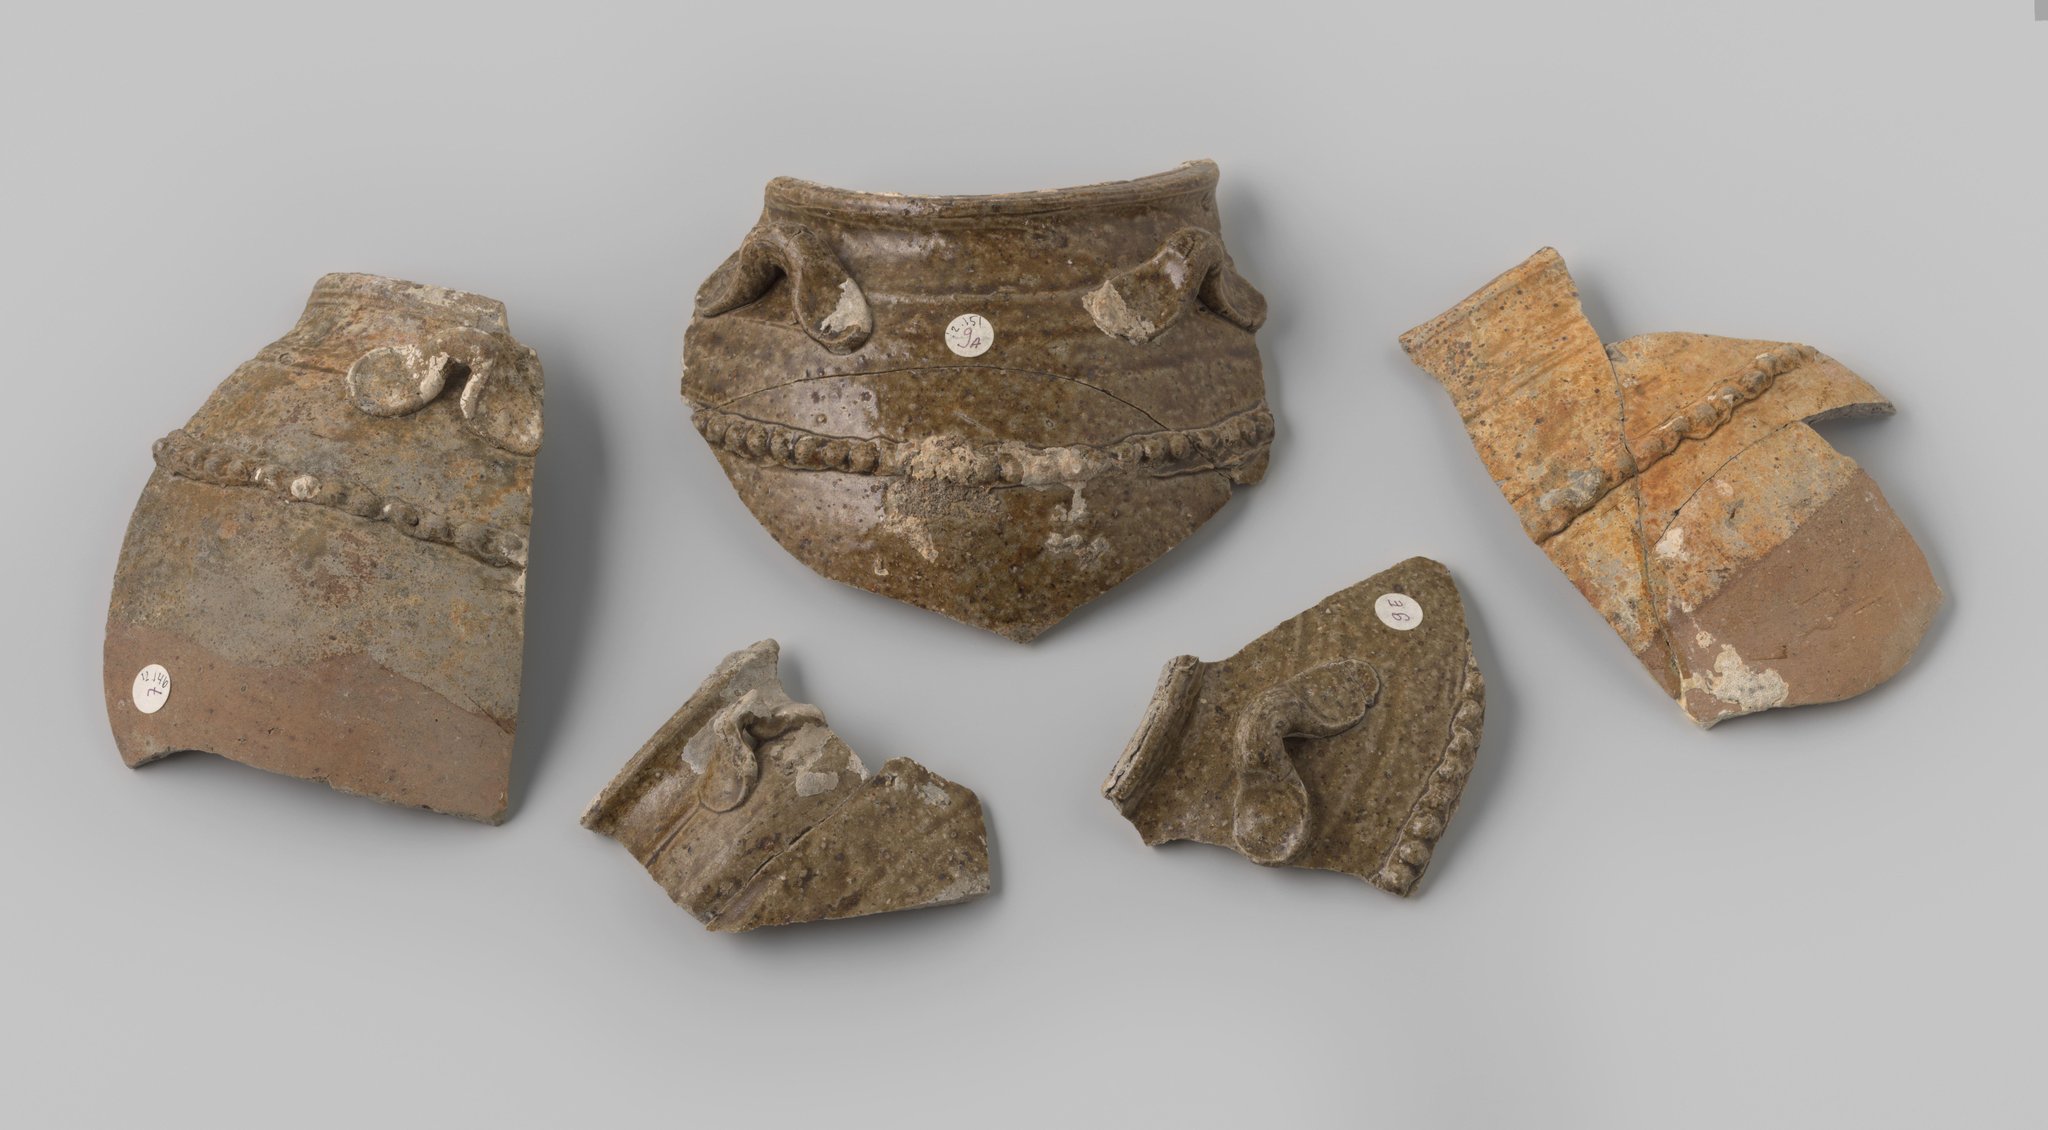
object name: martavaan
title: Scherven van martavanen uit V.O.C.-schip de 'Witte Leeuw'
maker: Anonymous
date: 1613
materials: glaze, porcelain, stoneware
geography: southeast asia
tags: verenigde oostindische compagnie, sint-helena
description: A jar. This jar has a short, straight, upright neck with a flattened, everted lip. The ears are connected by an incised band of about 1 cm wide. The clay is grey. The olive coloured glaze is still present. There is an applied band of pearls 4 cm beneath the ears. The glazed lip is slightly damaged as another piece of ceramic ware has been placed upon the jar during firing.